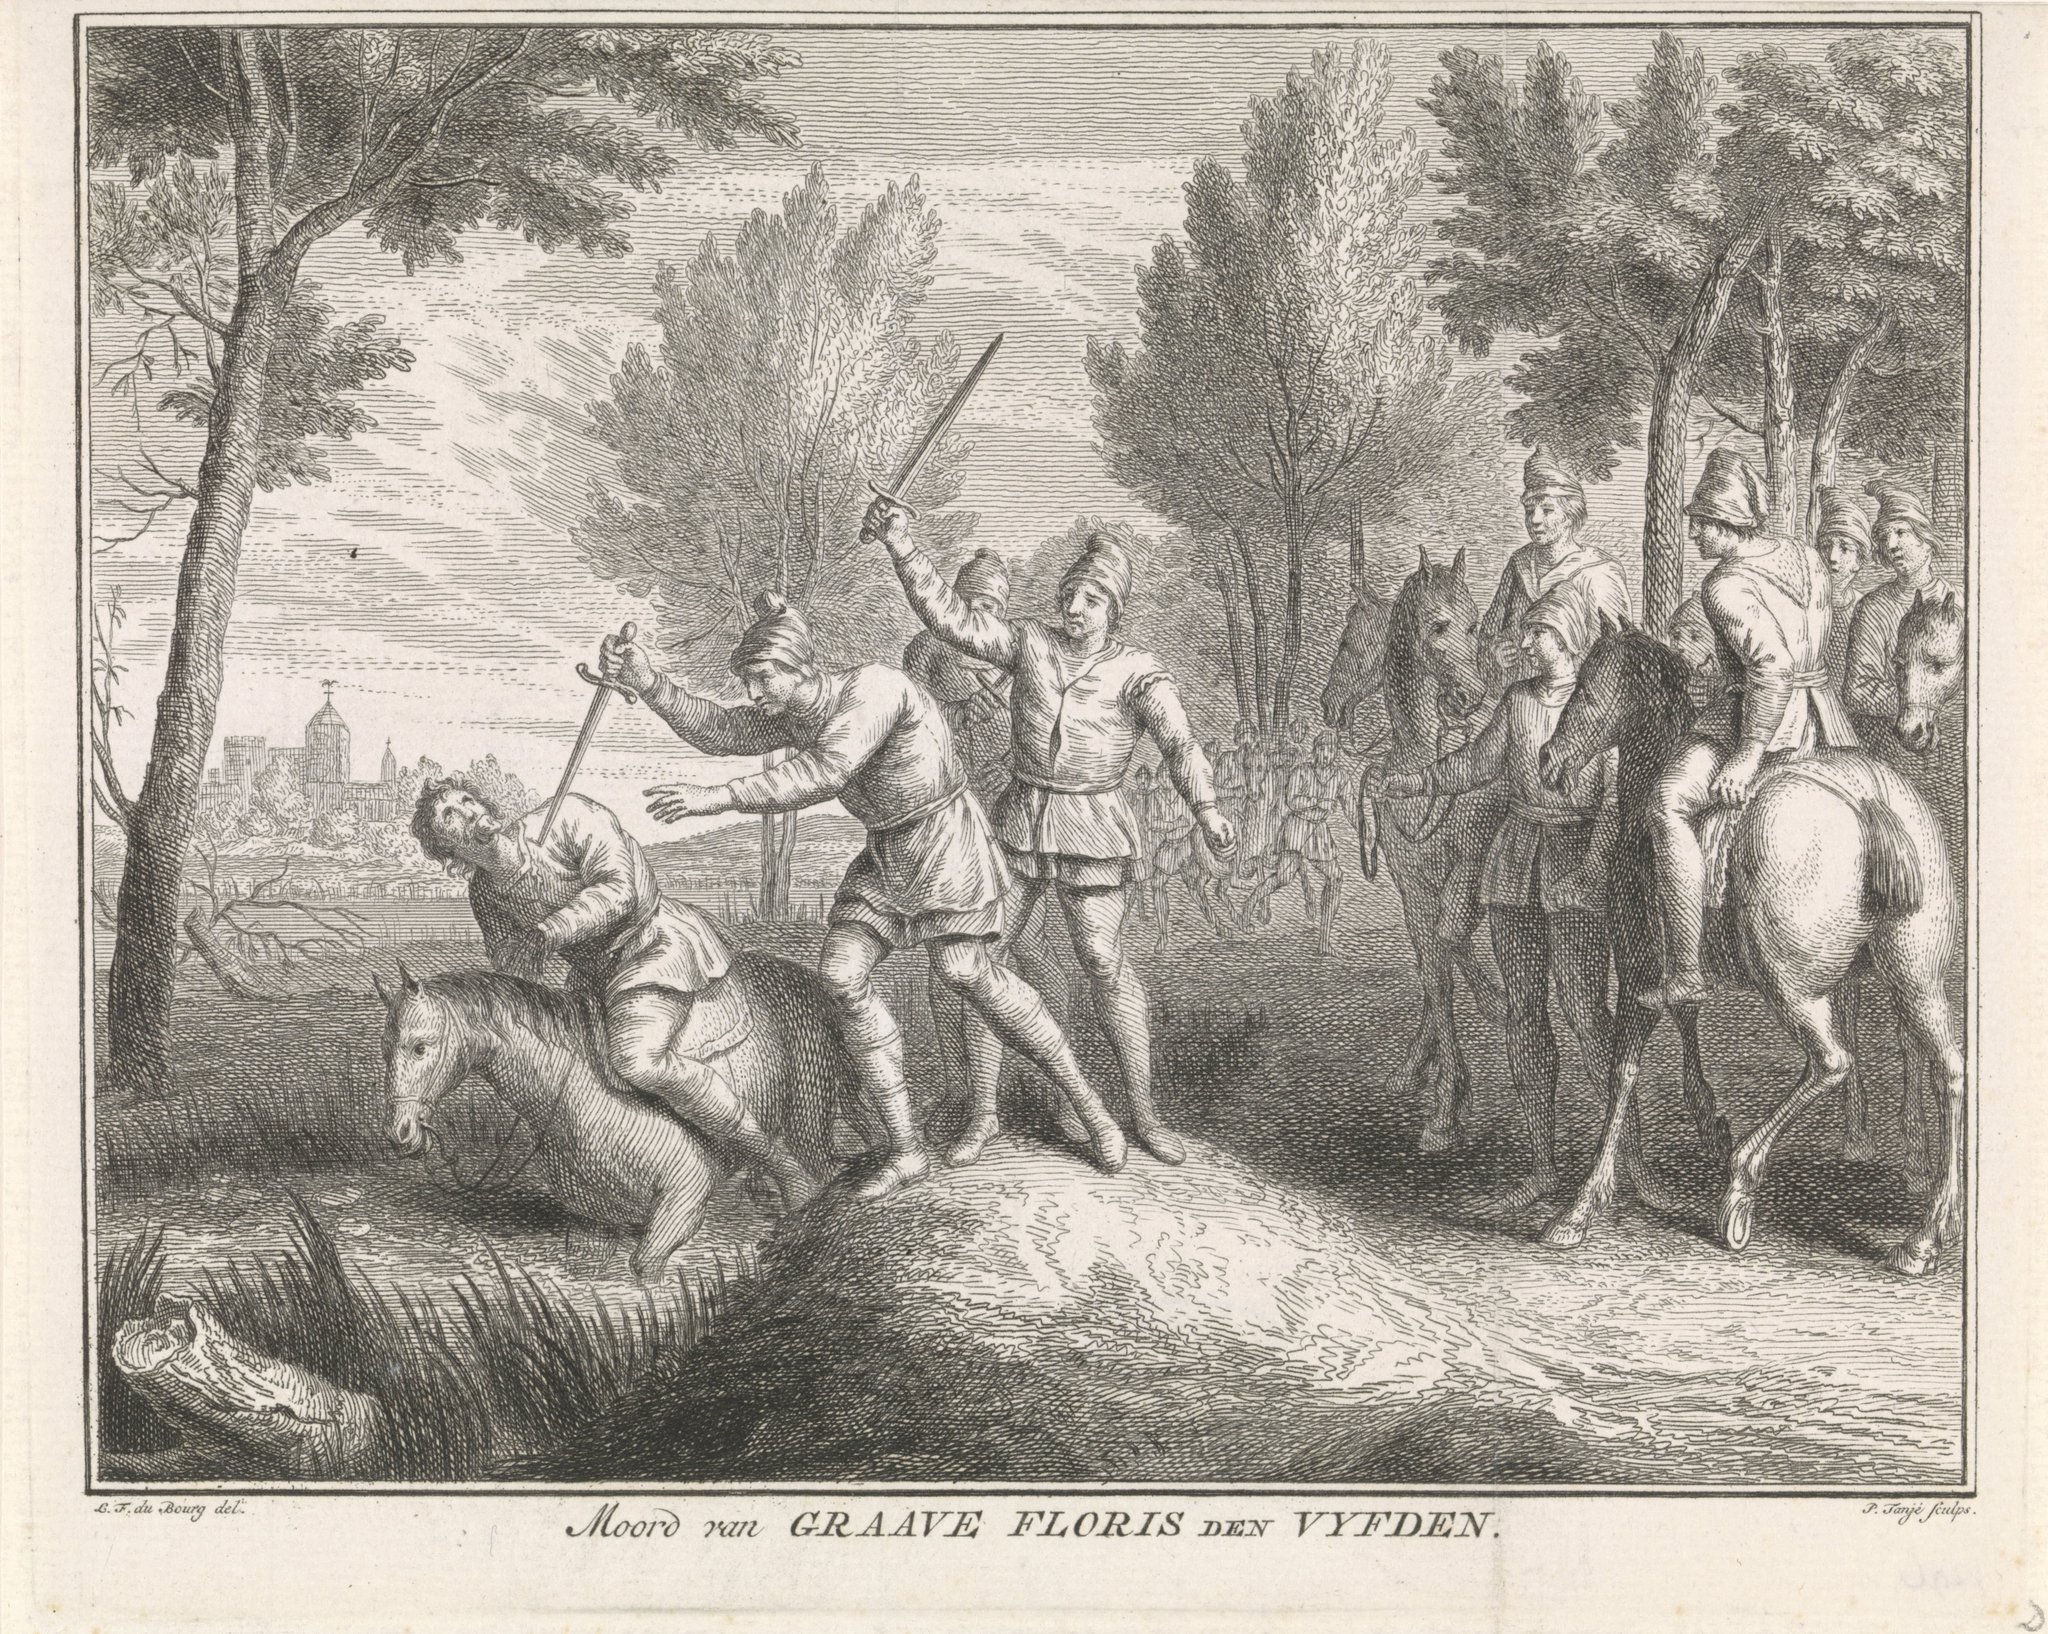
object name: history print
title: Moord op Floris V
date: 1747-1759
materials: paper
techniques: engraving, etching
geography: amsterdam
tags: floris v (graaf van holland en zeeland), violent death, being killed; being mishandled and maltreated; seeking death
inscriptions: collector's mark: Lugt 2228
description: Floris V vermoord door Gerard van Velzen, 26 juni 1296. De graaf die vastgebonden op zijn paard zit wordt door Gerard van Velzen met een zwaard gedood.